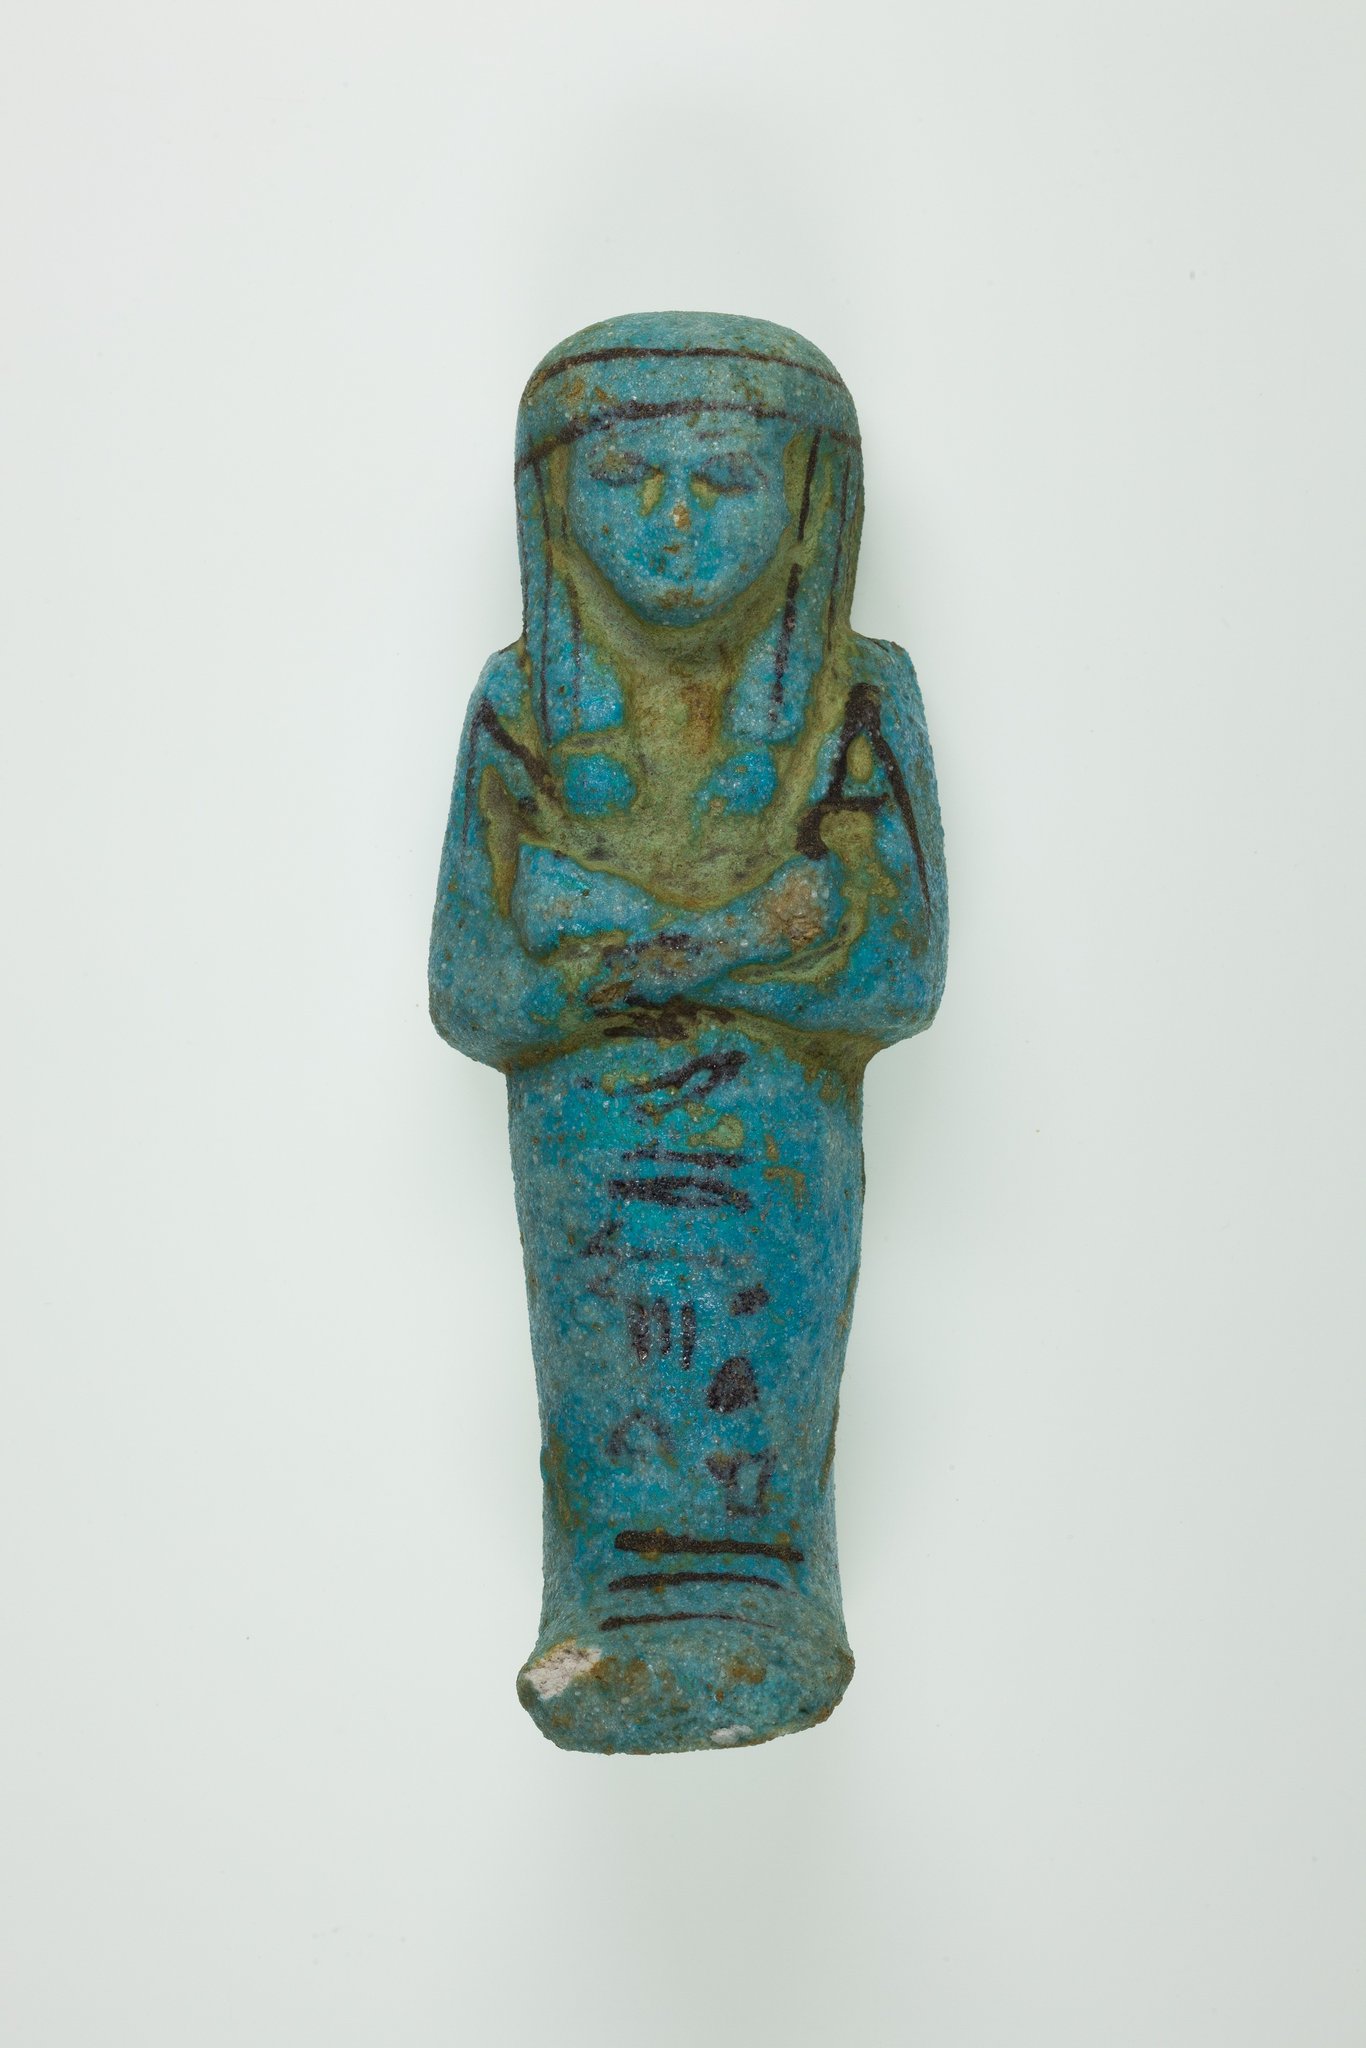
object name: worker shabti, henettawy c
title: Worker Shabti of Henettawy (C), Daughter of Isetemkheb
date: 990-970 BCE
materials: faience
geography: egypt